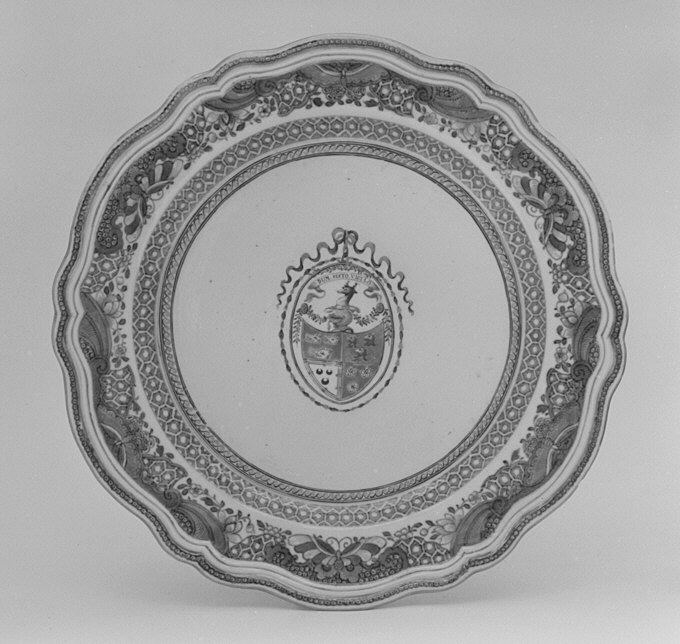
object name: soup plate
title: Soup plate (part of a service)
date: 1770-1785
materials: hard paste porcelain